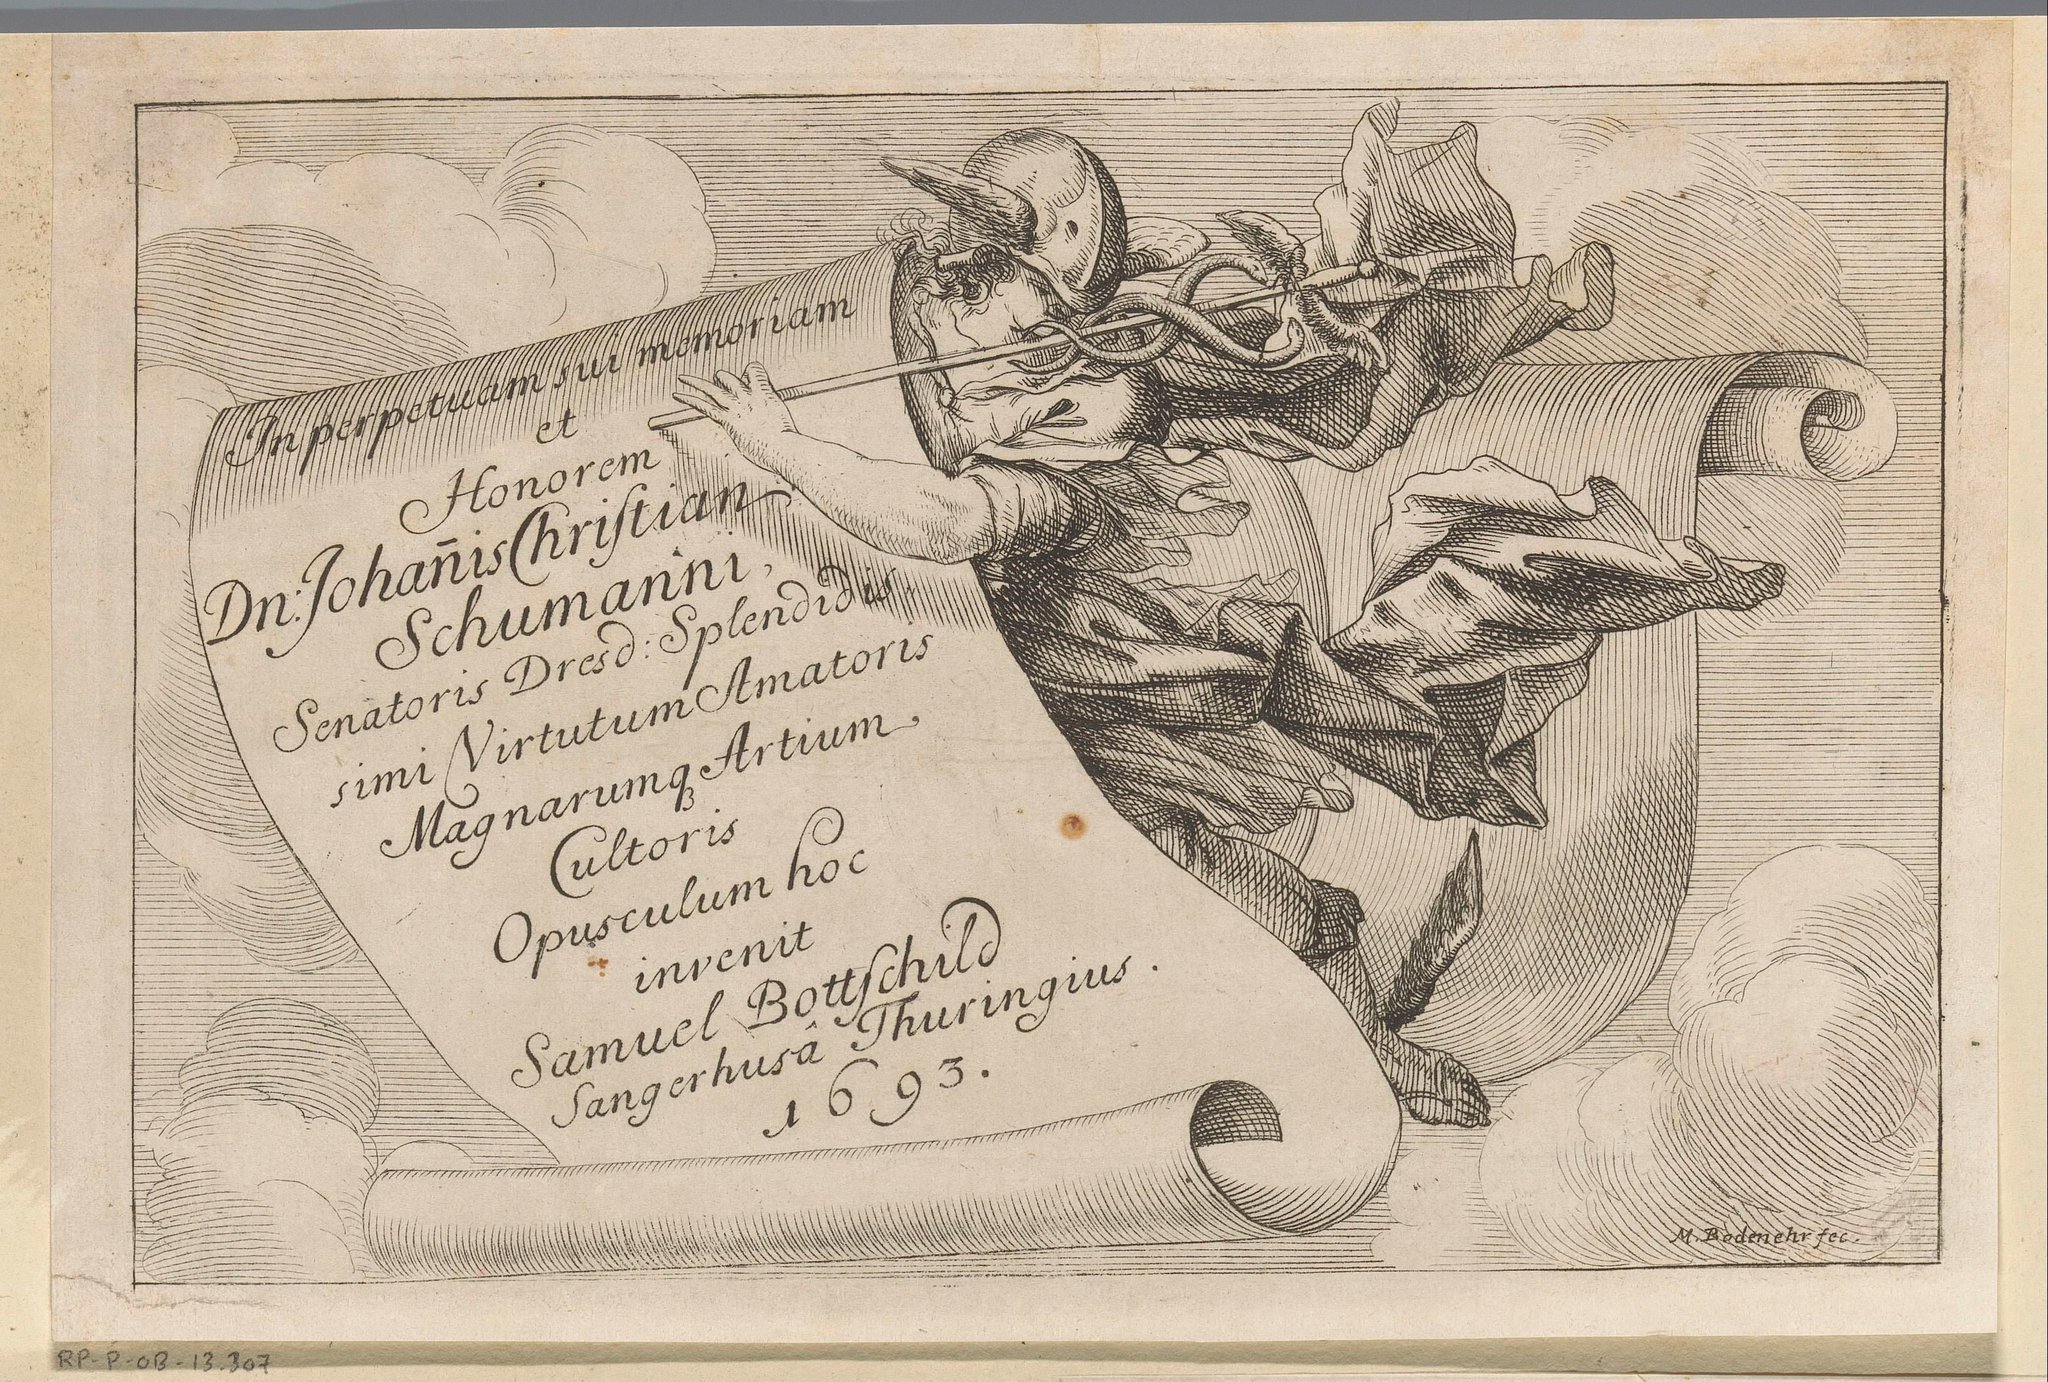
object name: print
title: Opera Varia Historica, Poetica & Iconologica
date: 1693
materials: paper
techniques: etching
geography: germany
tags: ribbon, scroll, banderole ~ ornament, specific aspects, allegorical aspects of mercury; mercury as patron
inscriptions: collector's mark: Lugt 240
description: Prent afkomstig uit de serie 'Opera Varia Historica, Poetica & Iconologica', uitgegeven in 1693. Deze serie omvat vrijwel het complete oeuvre van de Samuel Bottschild en bestaat uit 48 prenten, voornamelijk ontwerpen voor plafonds. De serie bevat ook een titelvignet, dedicatie aan Johann Christian Schumann en alfabet van de hand van Moritz Bodenehr.